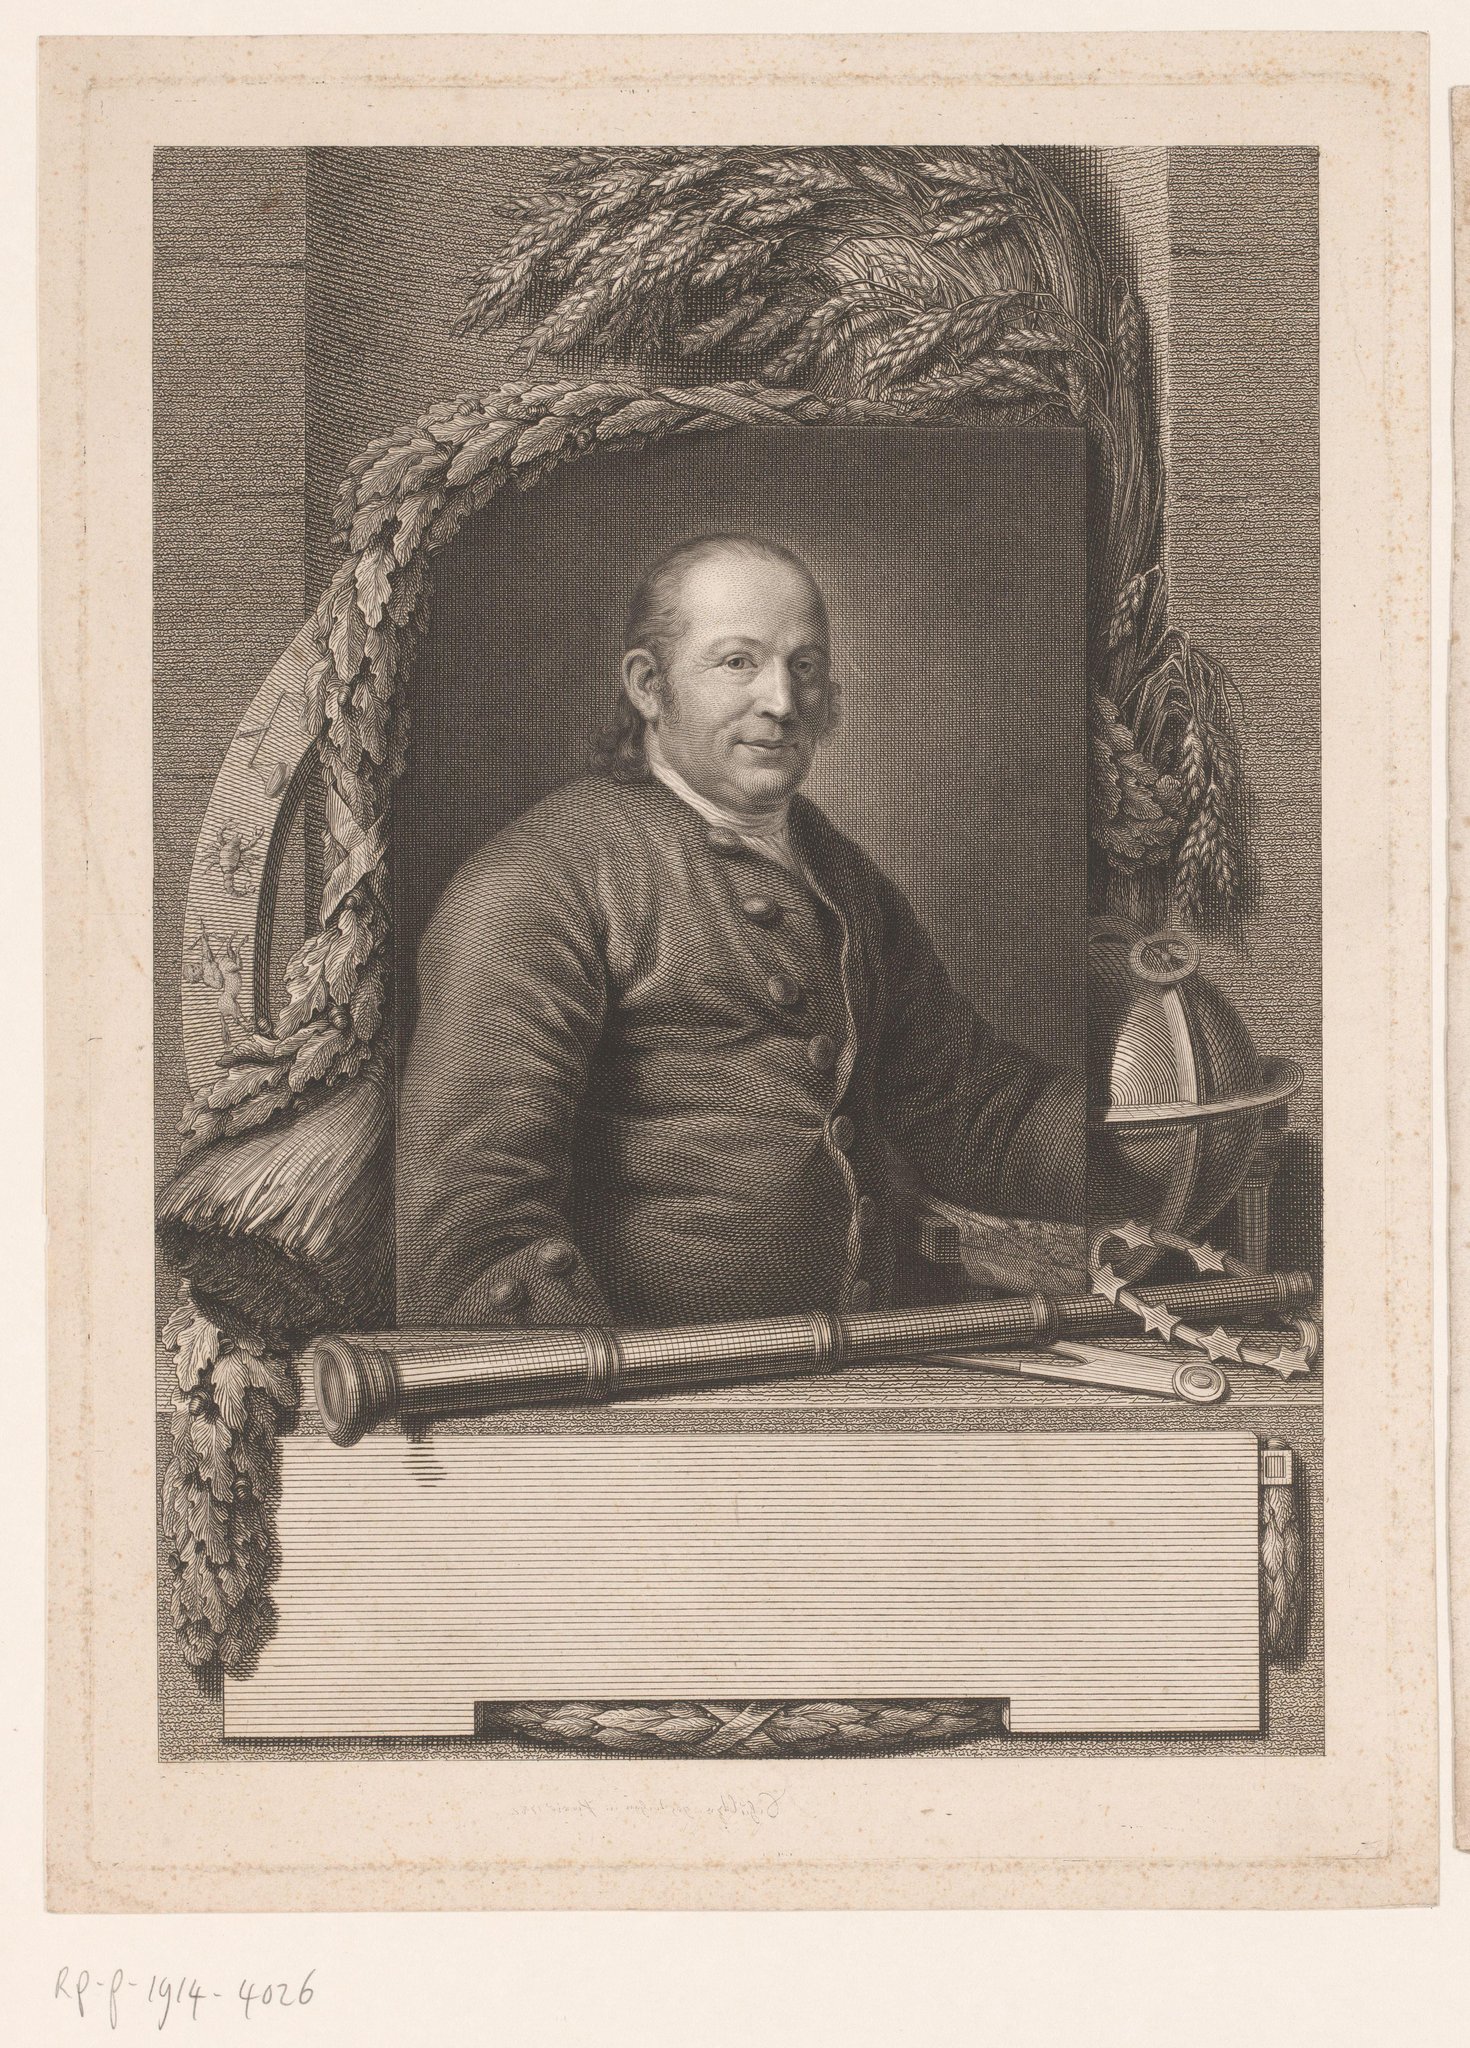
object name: print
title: Portret van Johann Georg Palitzsch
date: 1782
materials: paper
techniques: engraving, etching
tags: historical persons, astronomy (and cosmography)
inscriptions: collector's mark: Lugt 2228